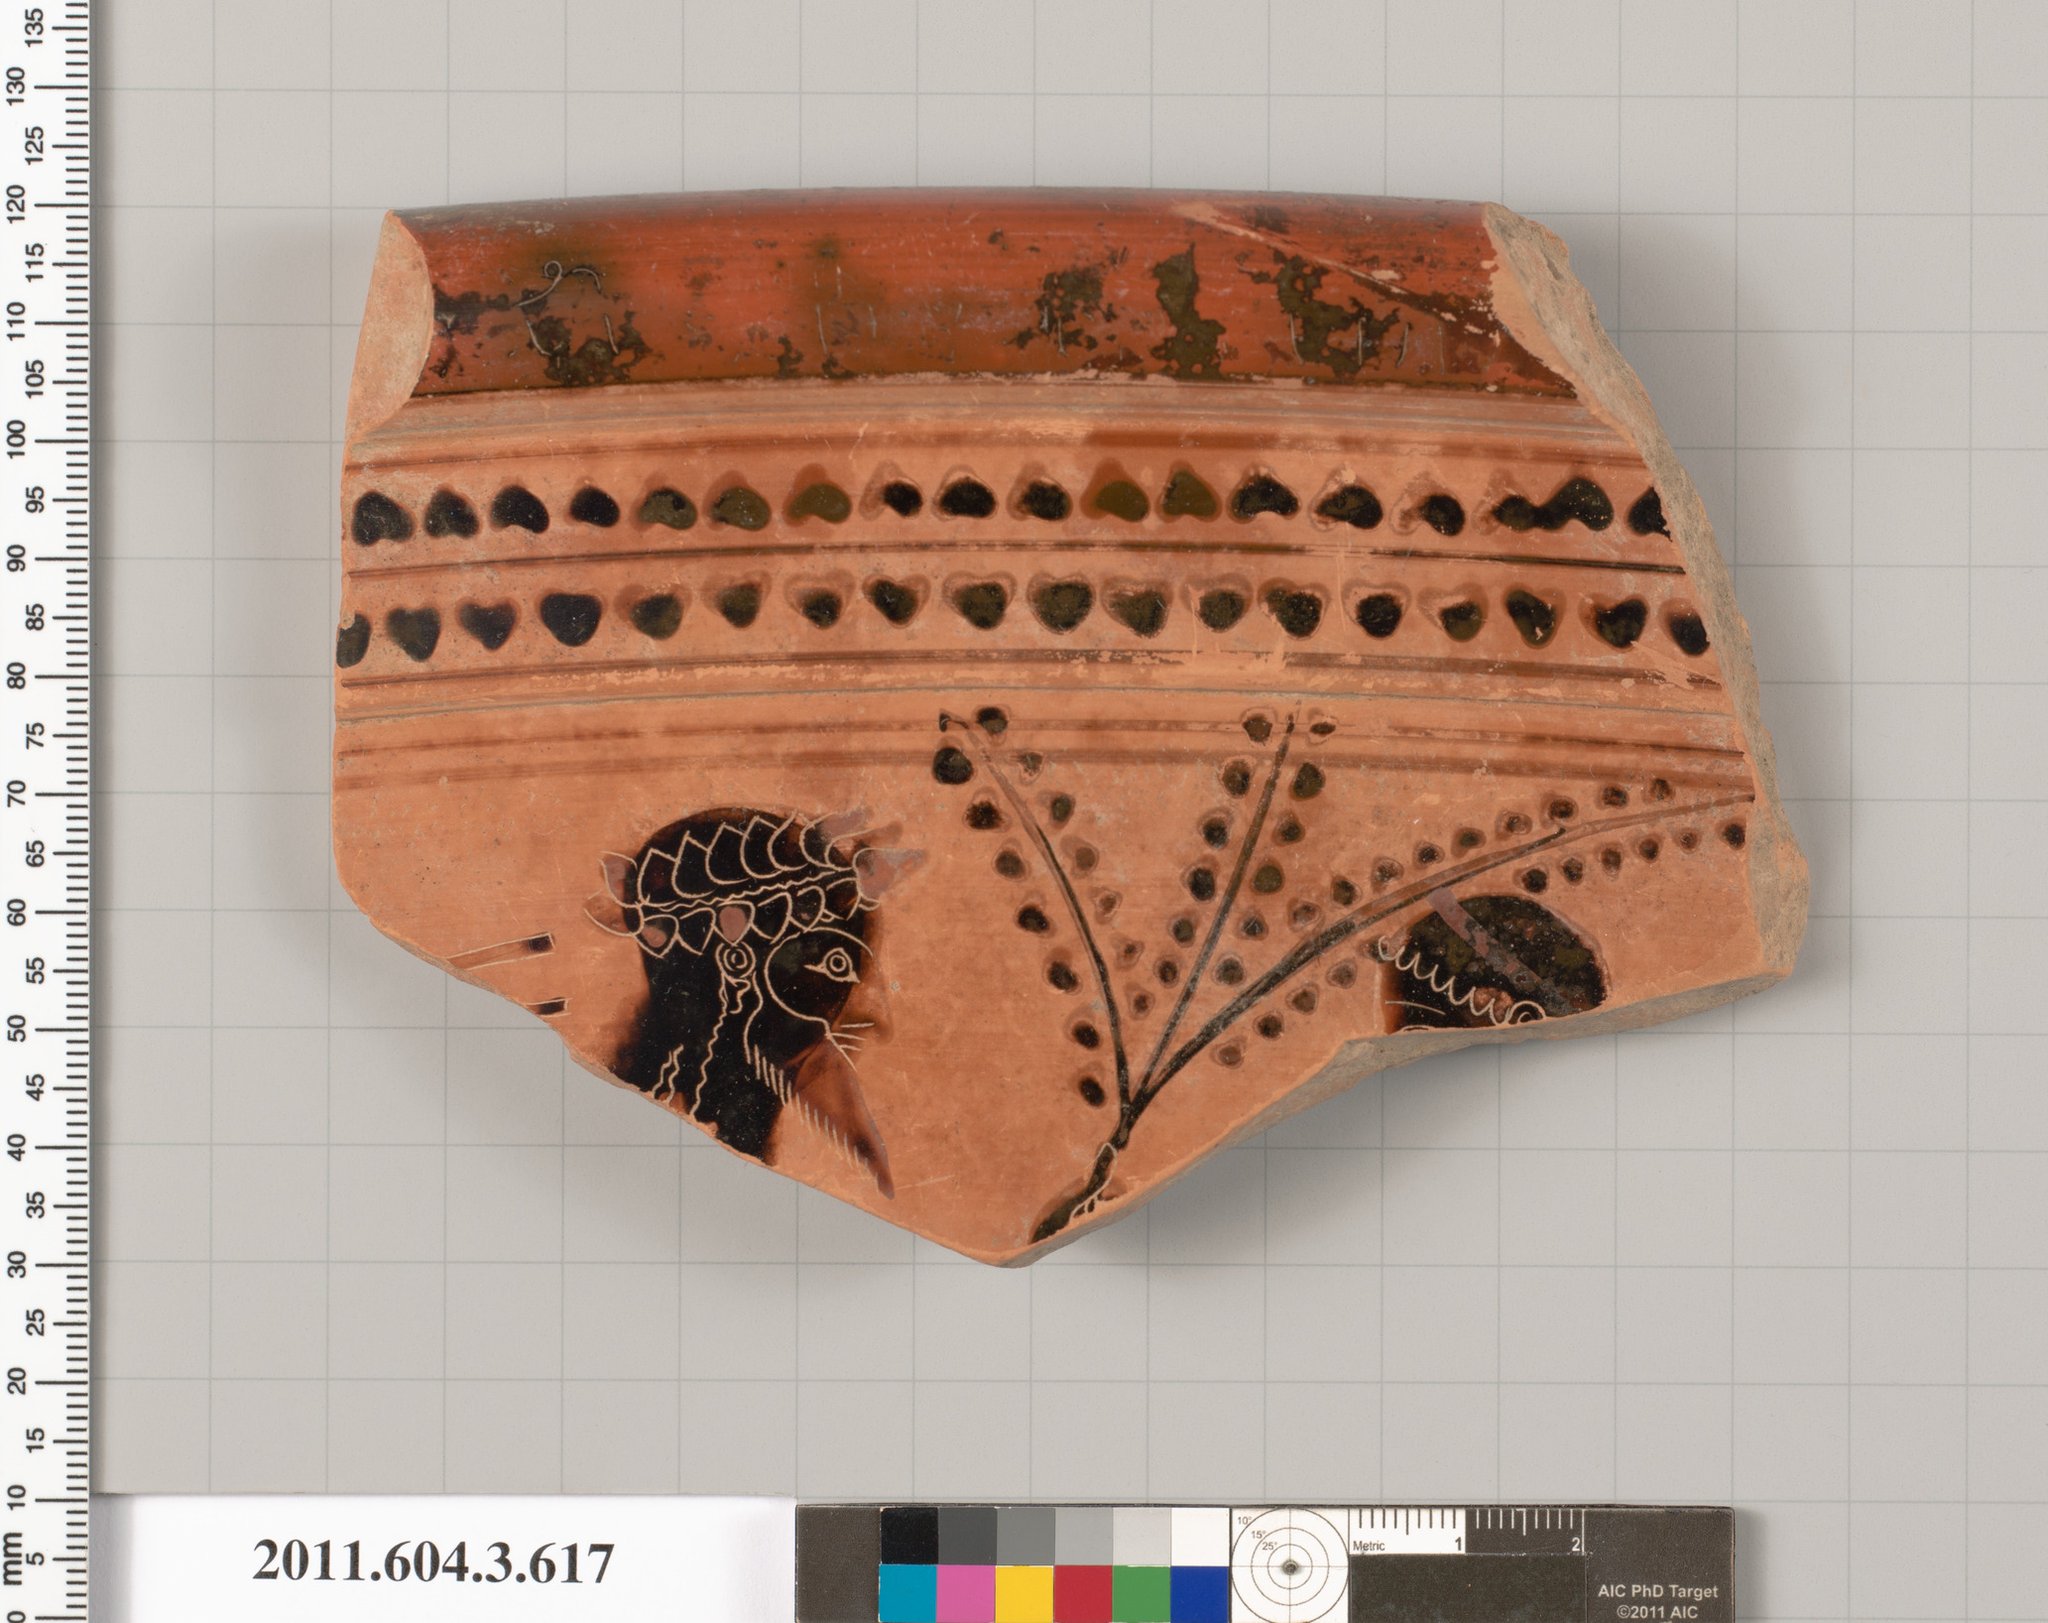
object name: calyx krater fragment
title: Terracotta fragment of a calyx-krater (bowl for mixing wine and water)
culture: greek, attic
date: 534-501 BCE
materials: terracotta